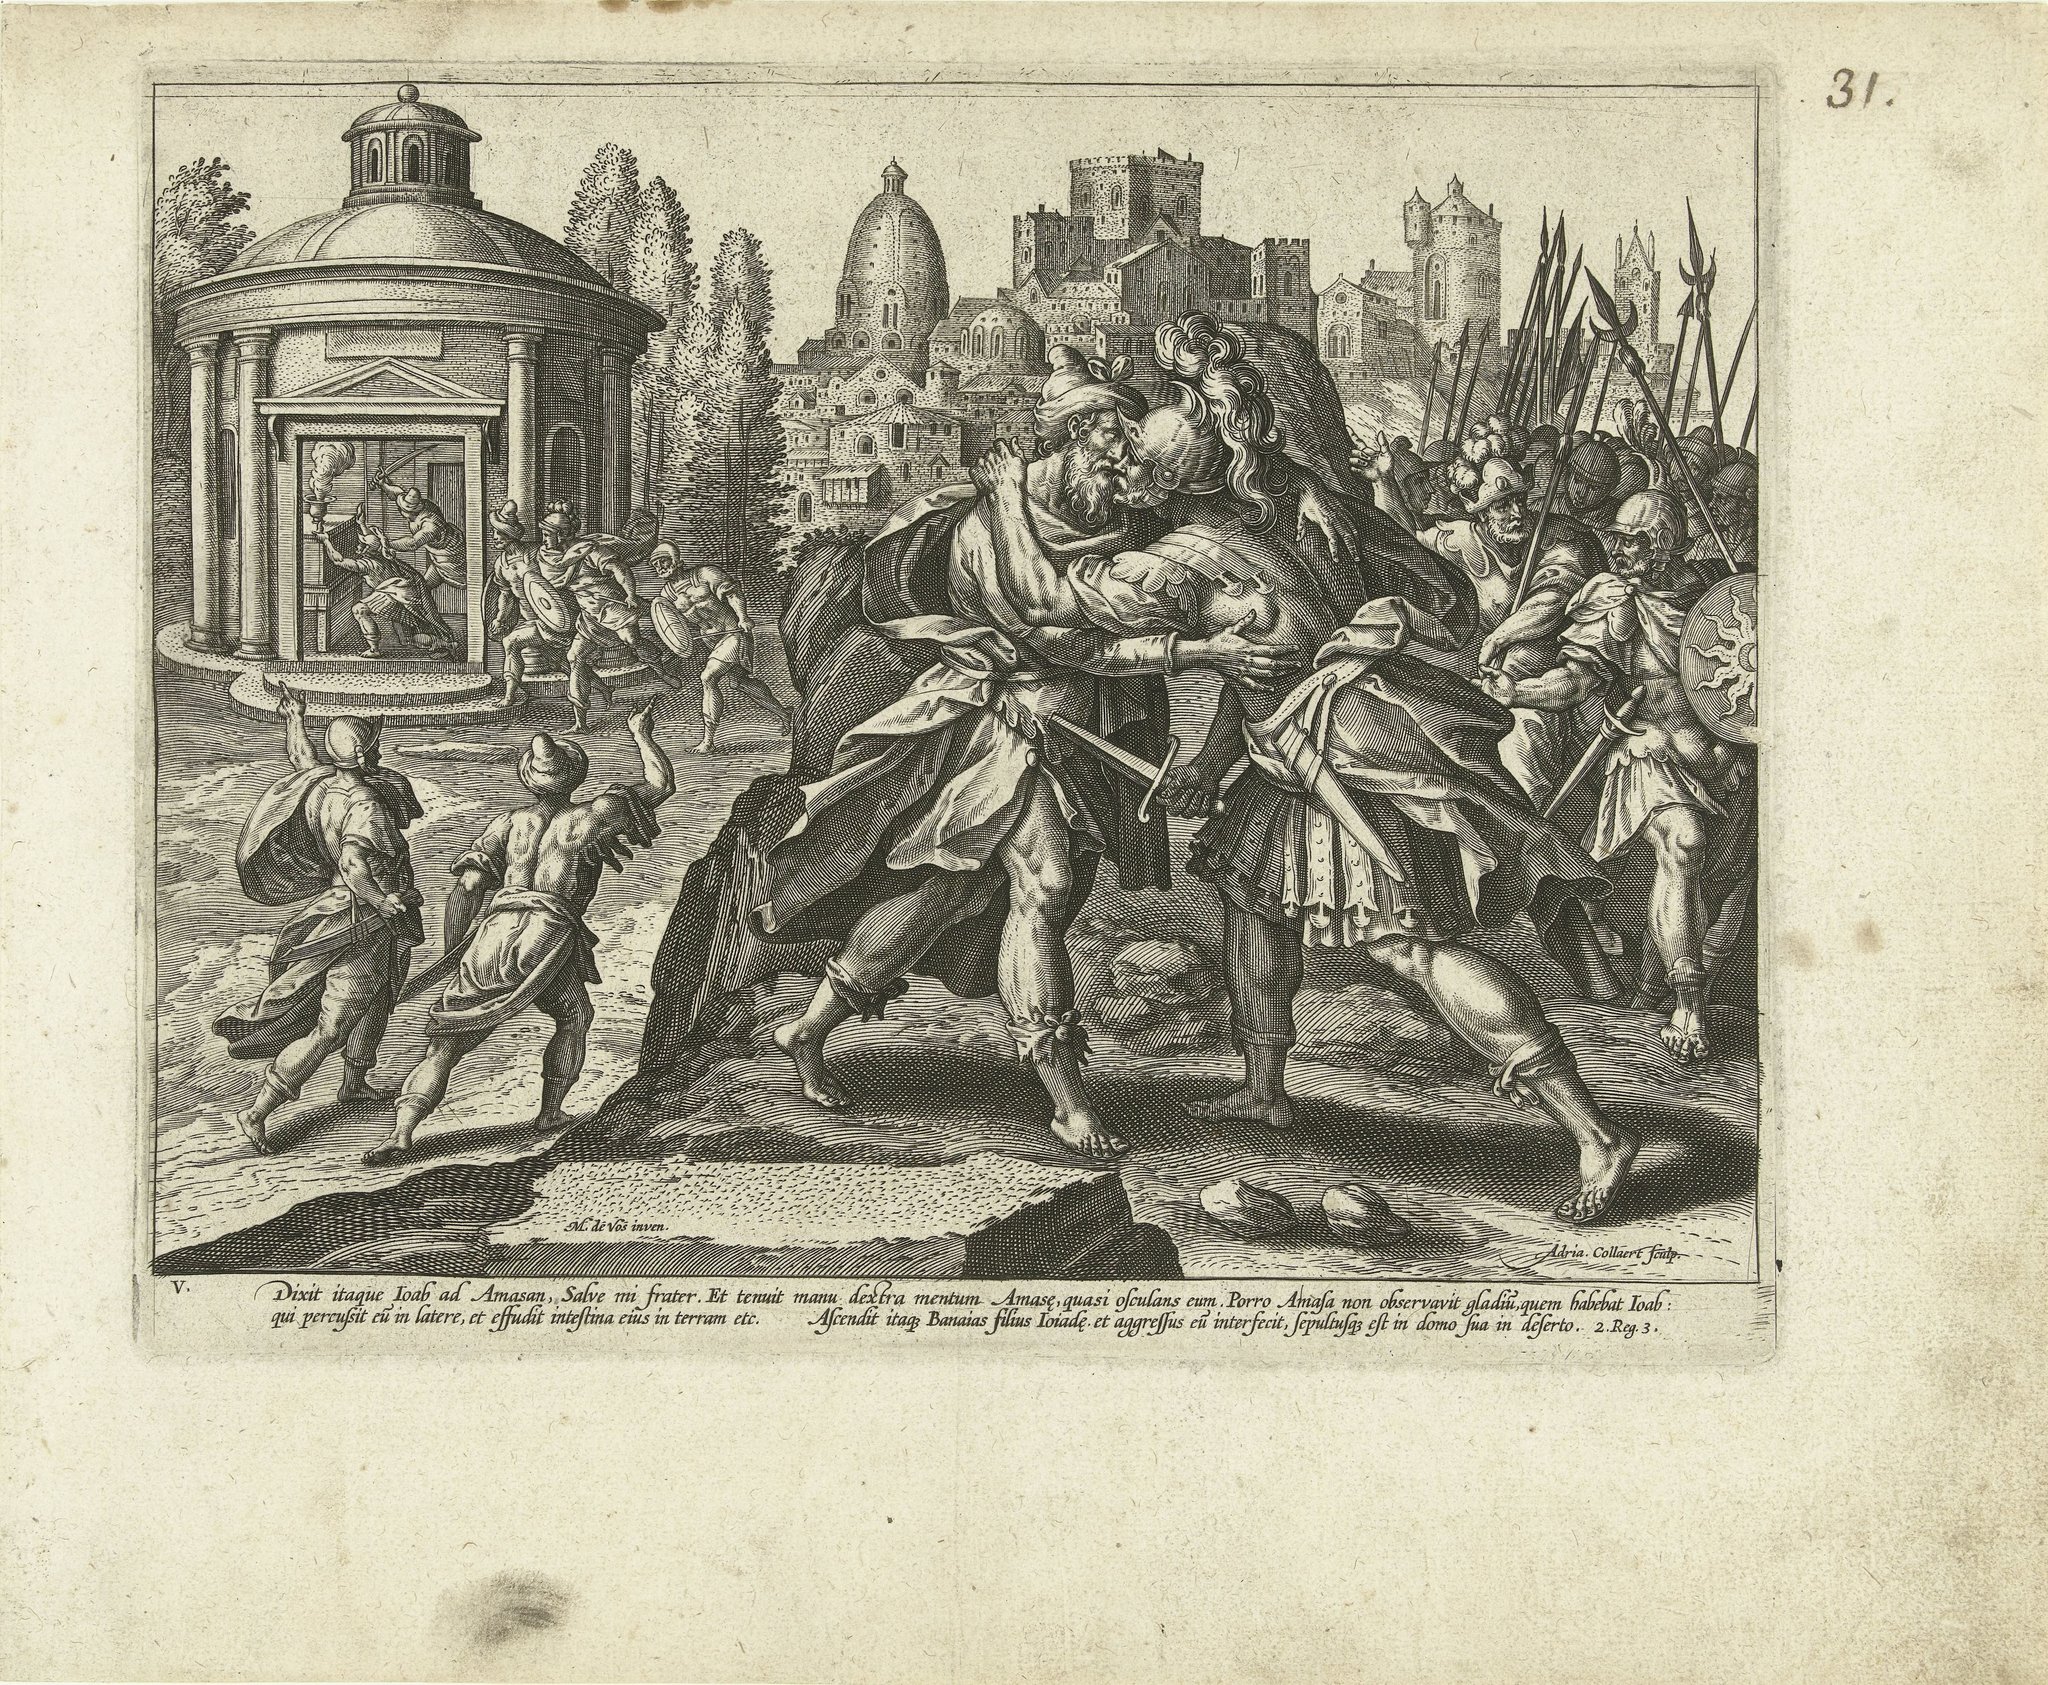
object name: print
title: Tien Geboden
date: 1585-1589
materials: paper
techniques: engraving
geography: antwerp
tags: joab kills amasa: joab takes amasa by the beard with the right hand as if to kiss him, and stabs him with a dagger, joab killed by benaiah, joab flees to the tabernacle and takes hold of the horns of the altar, 'you shall not kill' ~ separate representation of the sixth of the ten commandments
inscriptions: number: ‘31’, collector's mark: Lugt 2760, collector's mark: Lugt 2228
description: Joab verraadt Amasa en vermoordt hem zonder de toestemming van David. Hij steekt hem neer onder het mom van een vriendschappelijke omhelzing (2 Samuël 20:8-12). Dit is een schending van het vijfde Gebod: "Gij zult niet doden". Op de achtergrond het gevolg van deze daad. Joab wordt op zijn beurt door Salomo's soldaten vermoordt, terwijl hij bescherming zoekt in de tempel. De prent heeft een Latijns onderschrift. De prentserie beeldt de Tien Geboden uit door middel van scènes van het Oude Testament.